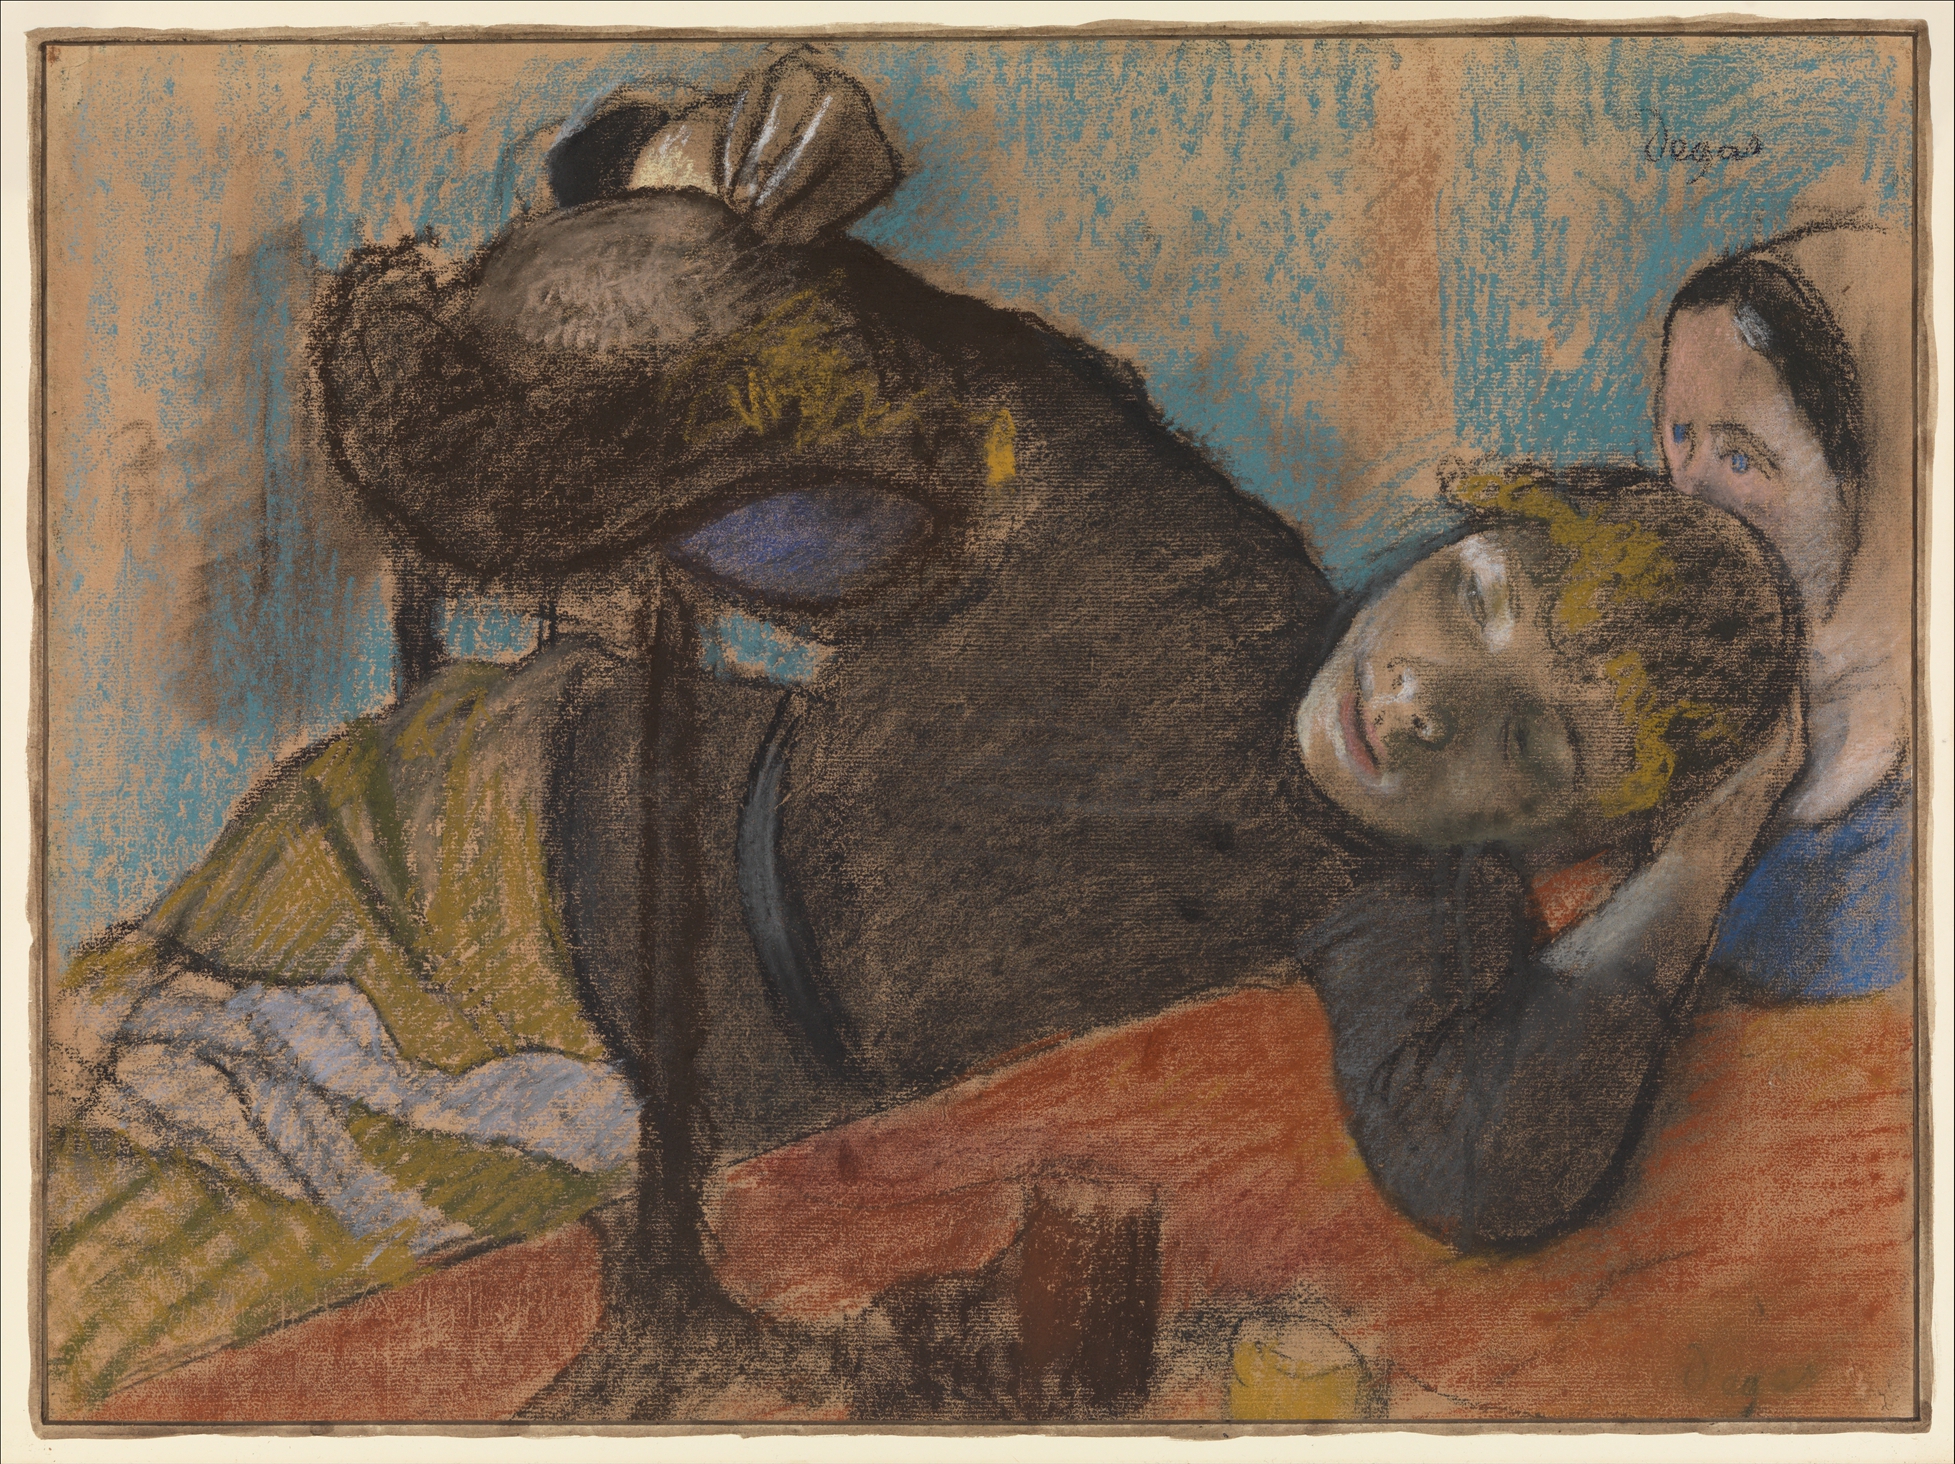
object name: drawing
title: The Milliner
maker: edgar degas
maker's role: artist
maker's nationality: french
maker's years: 1834-1917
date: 1882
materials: charcoal, pastel, paper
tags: hats,women